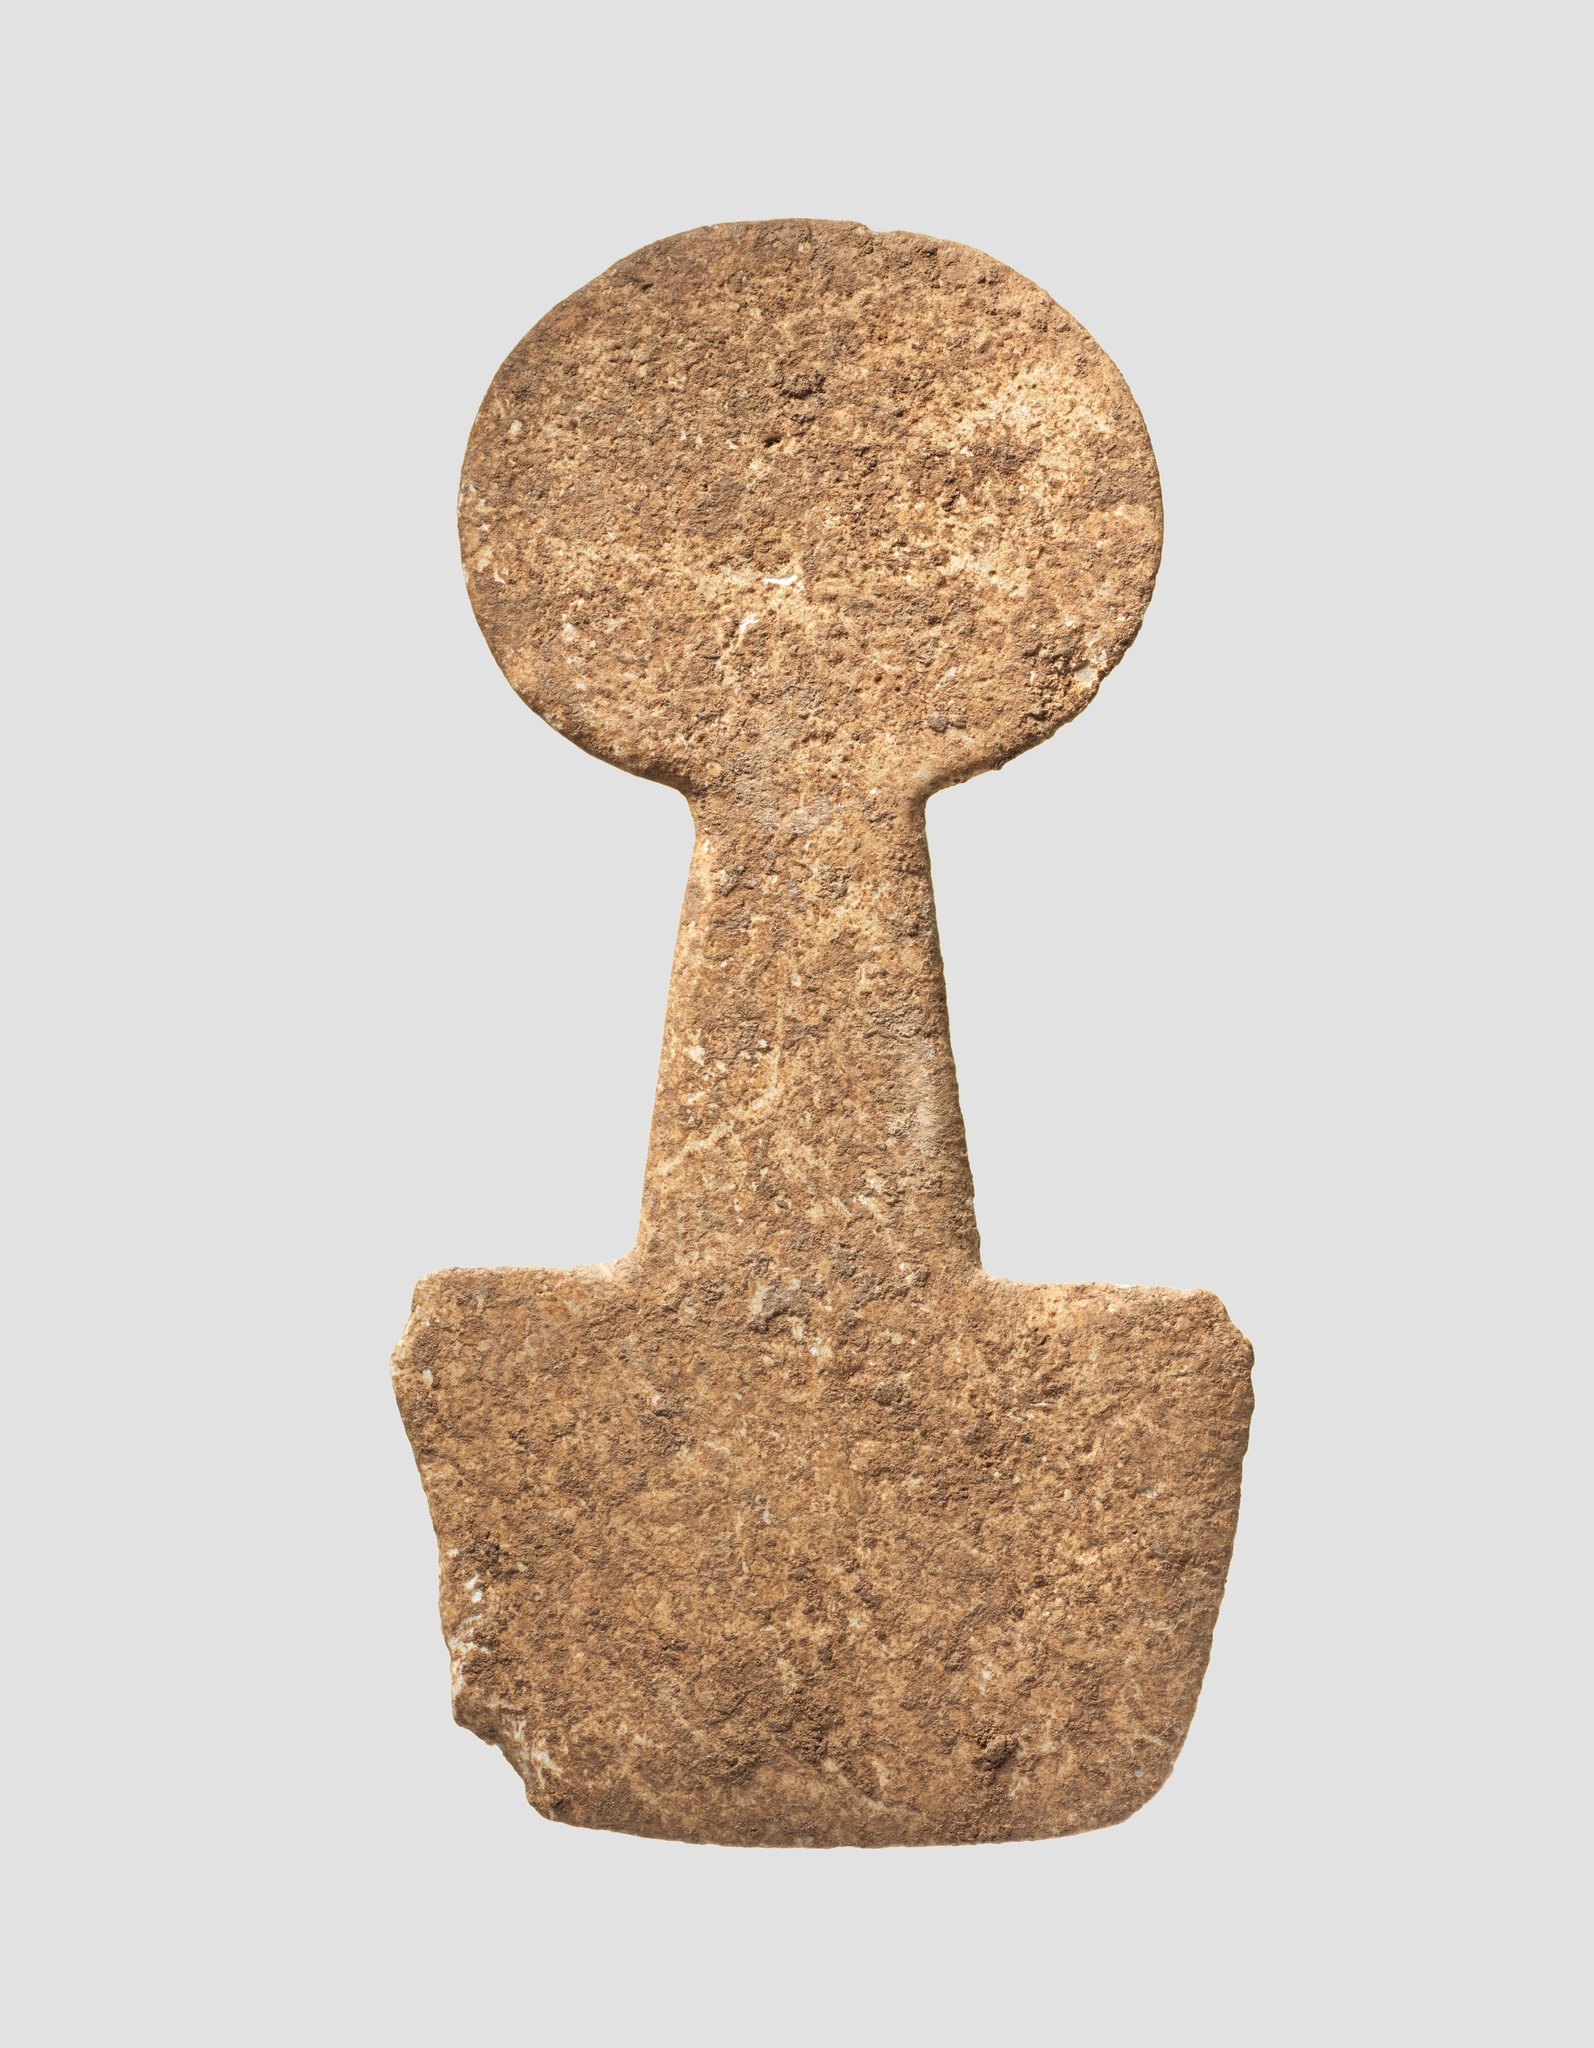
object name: sculpture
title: Spade-shaped schematic female (?) figure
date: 3000-2800 BCE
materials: limestone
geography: anatolia